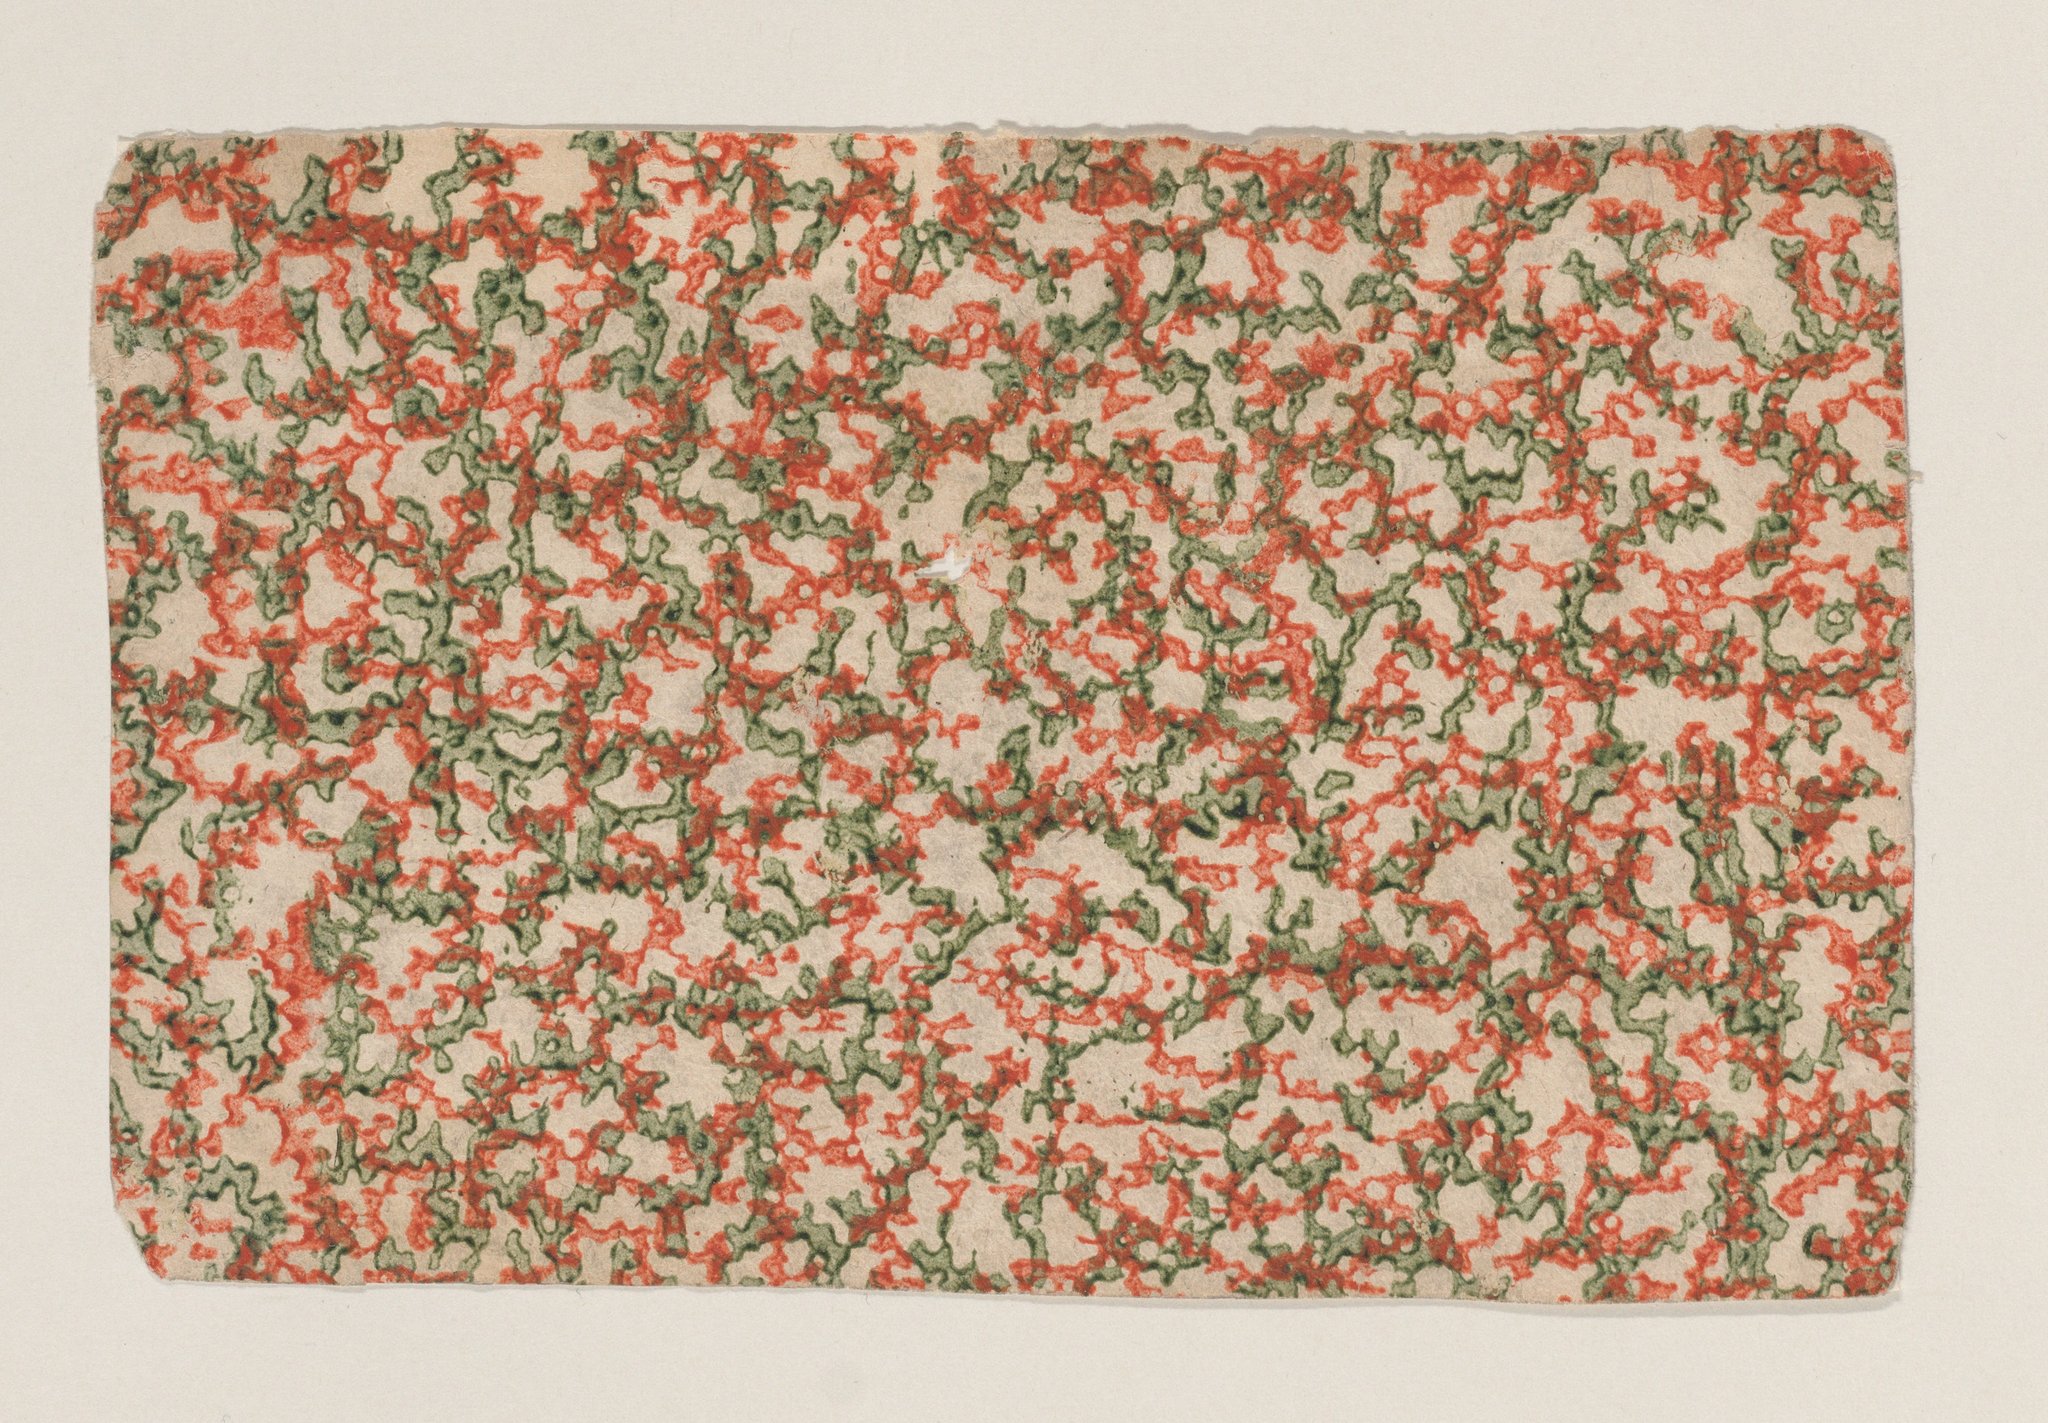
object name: print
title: Sheet with overall orange and green abstract pattern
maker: Anonymous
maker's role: artist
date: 1801-1900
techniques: relief print